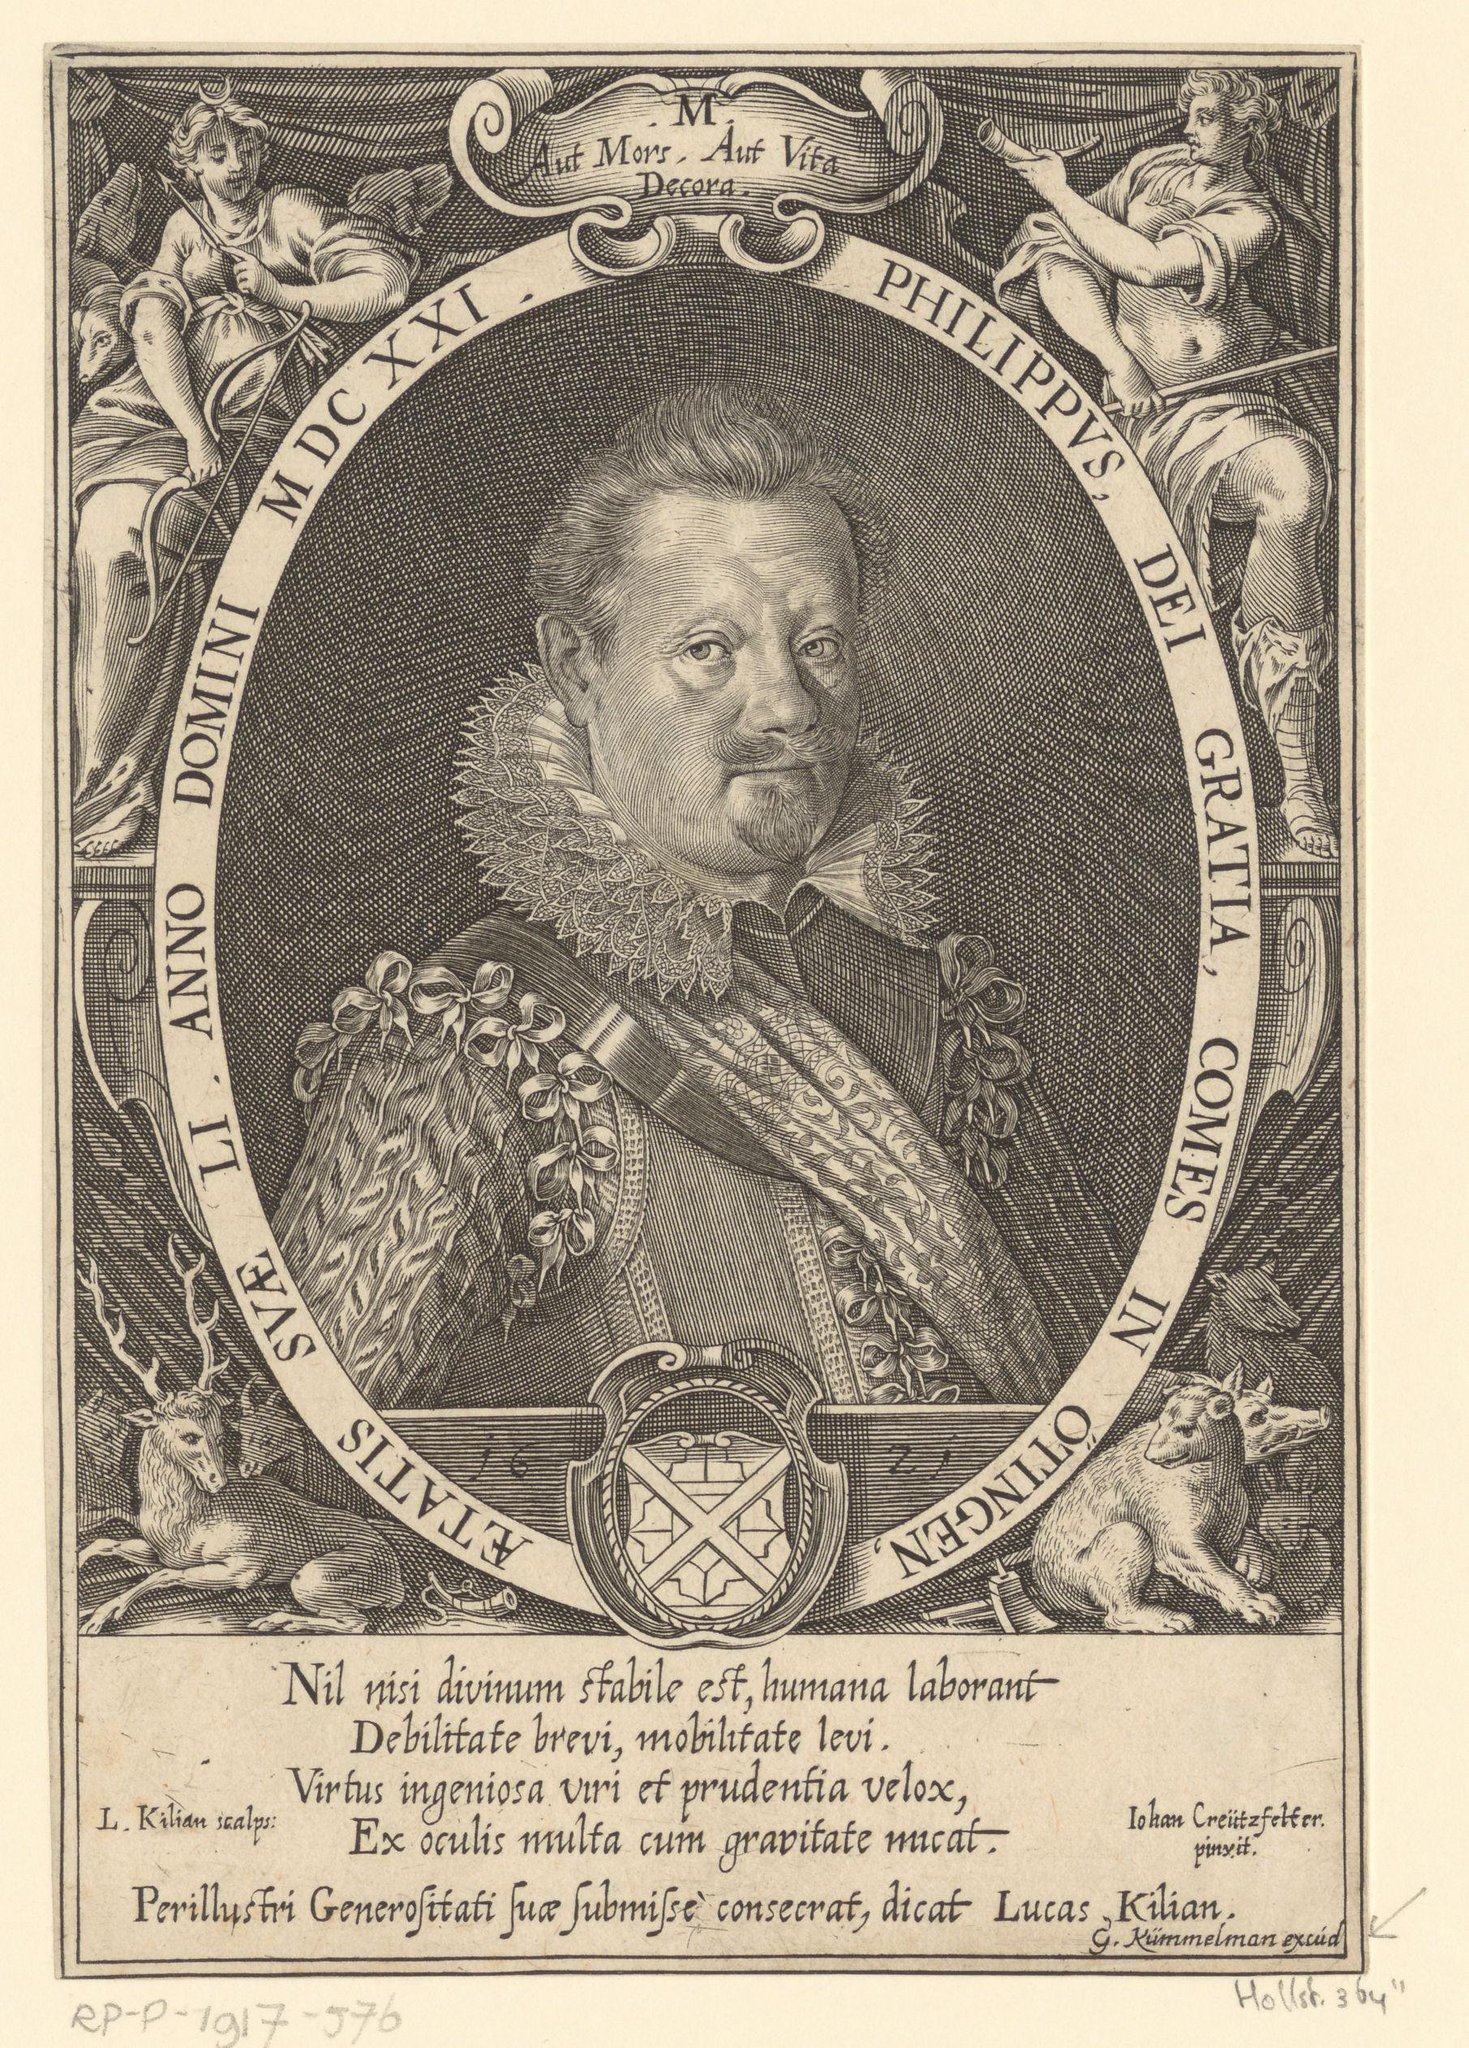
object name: print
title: Portret van Philipp von Oettingen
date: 1621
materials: paper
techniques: engraving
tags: philipp von oettingen (graaf), hunting, chase, historical persons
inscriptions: collector's mark: Lugt 2228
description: Tekst in het Latijn in de omlijsting en in de ondermarge.